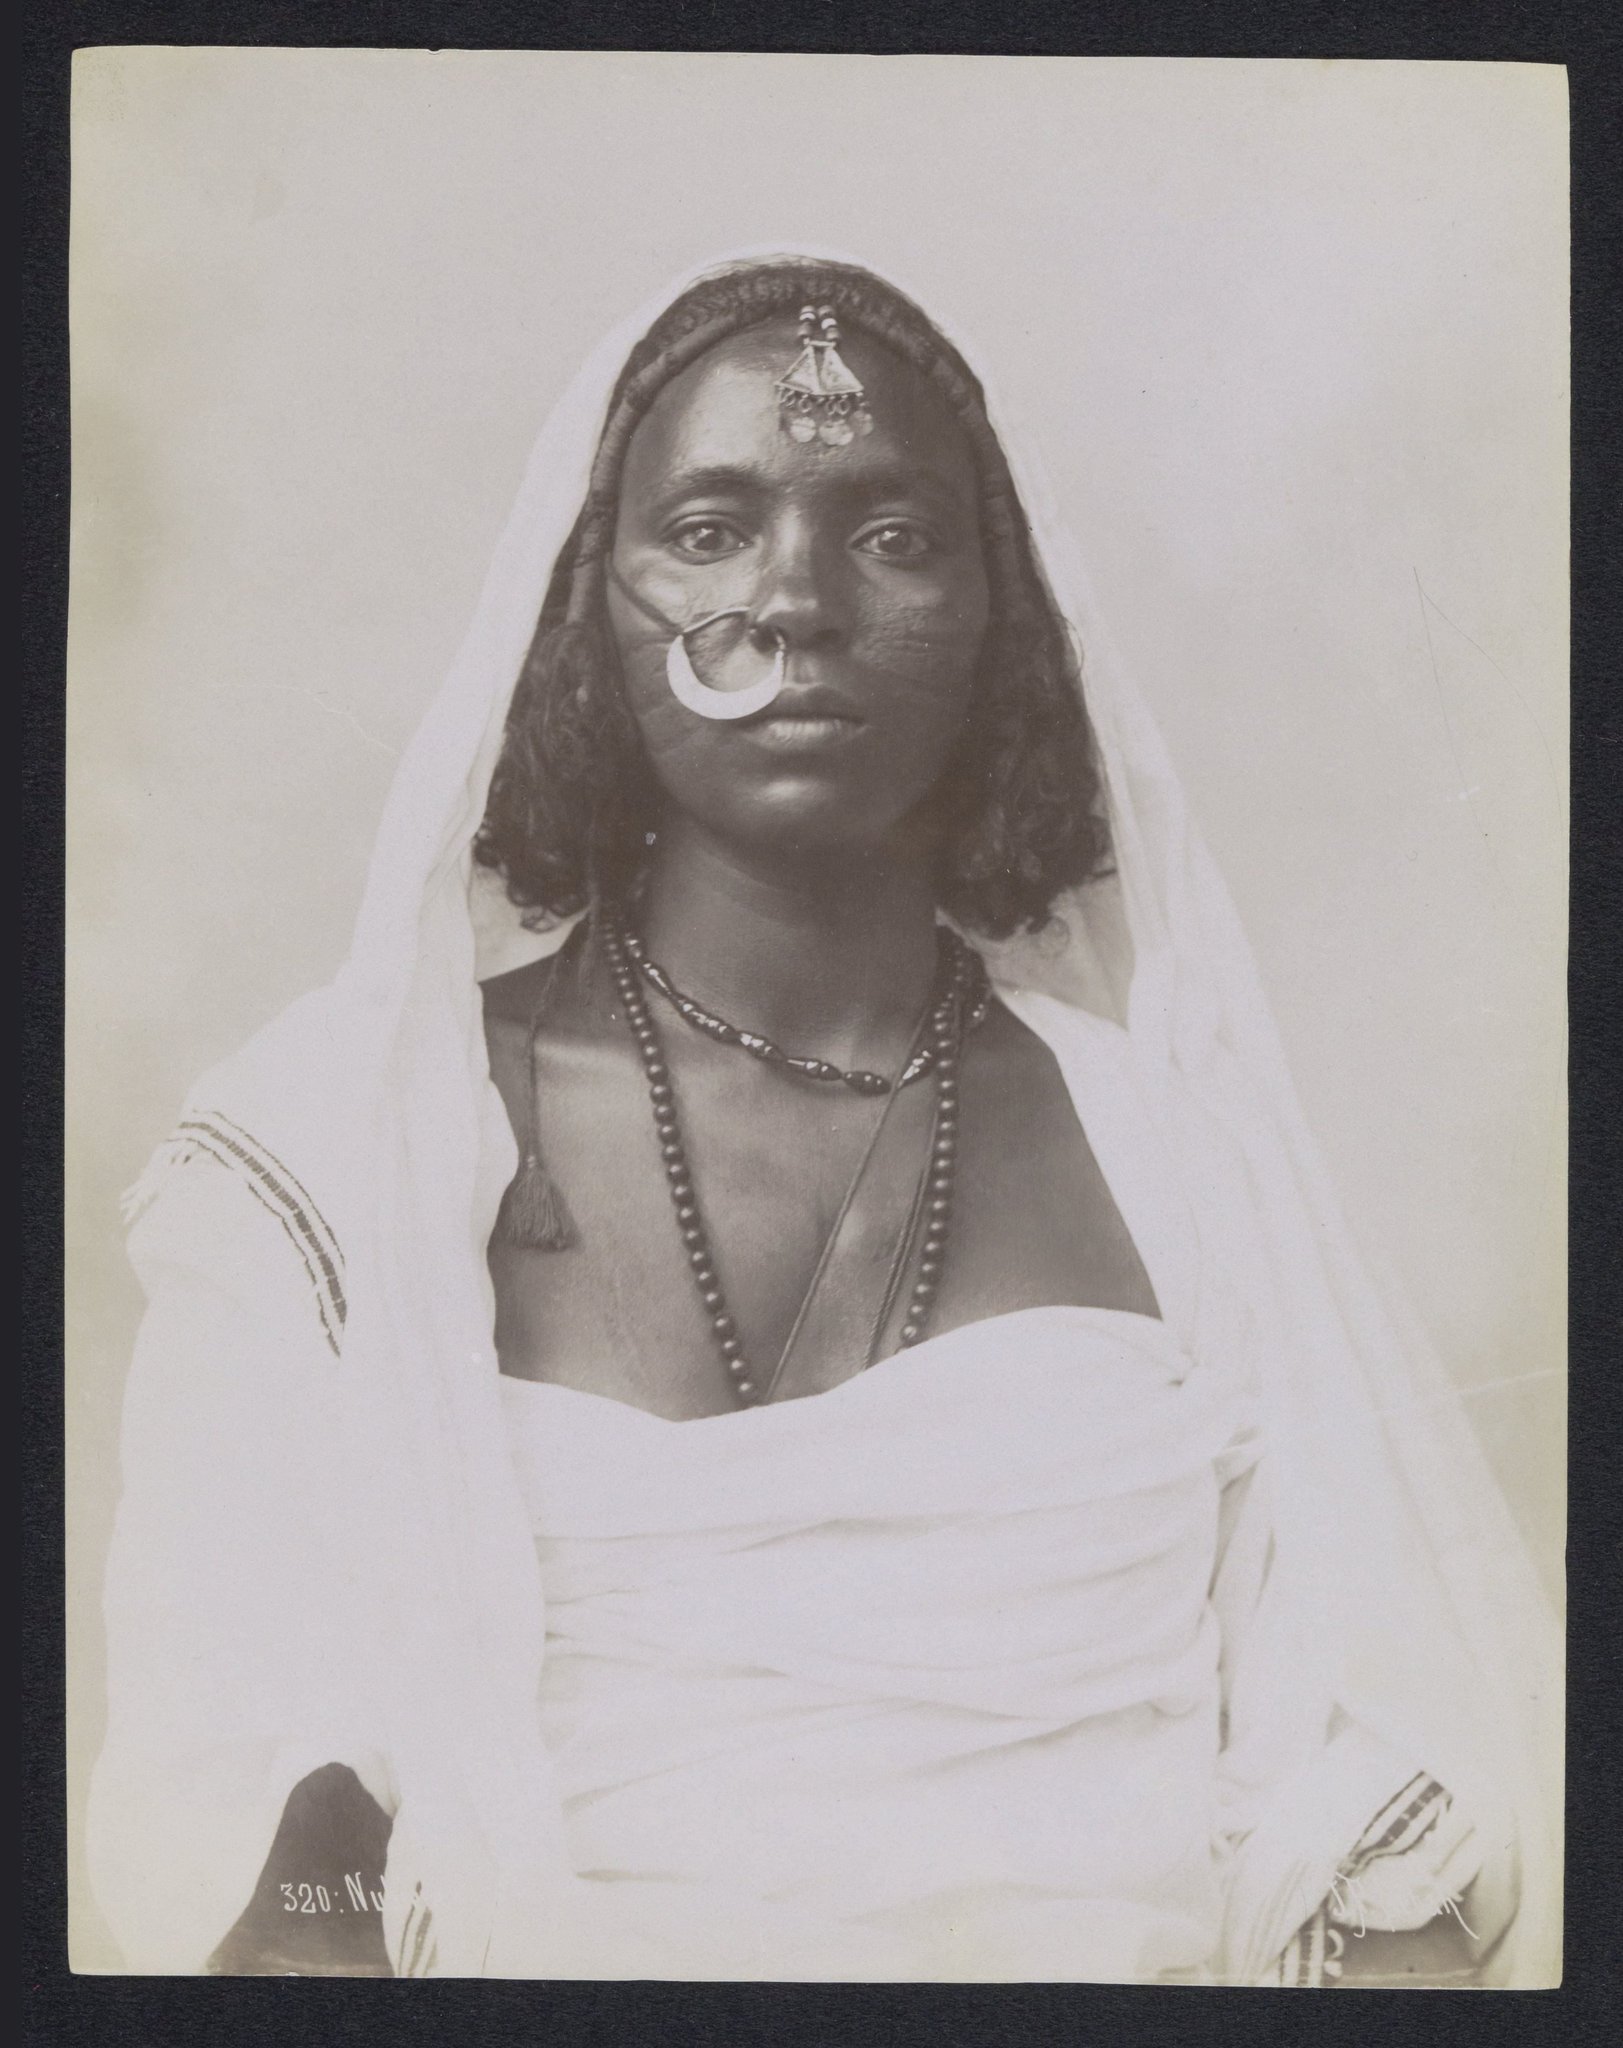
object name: photograph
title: Nubienne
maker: jean pascal sébah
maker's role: fotograaf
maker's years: 1872-1947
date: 1888-1918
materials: paper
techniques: albumen print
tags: african peoples, africans (nubians), anonymous historical person portrayed - bb - woman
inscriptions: number: ‘320’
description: Onbekende vrouw beschreven als Nubisch naar aanleiding van de titel op het object.